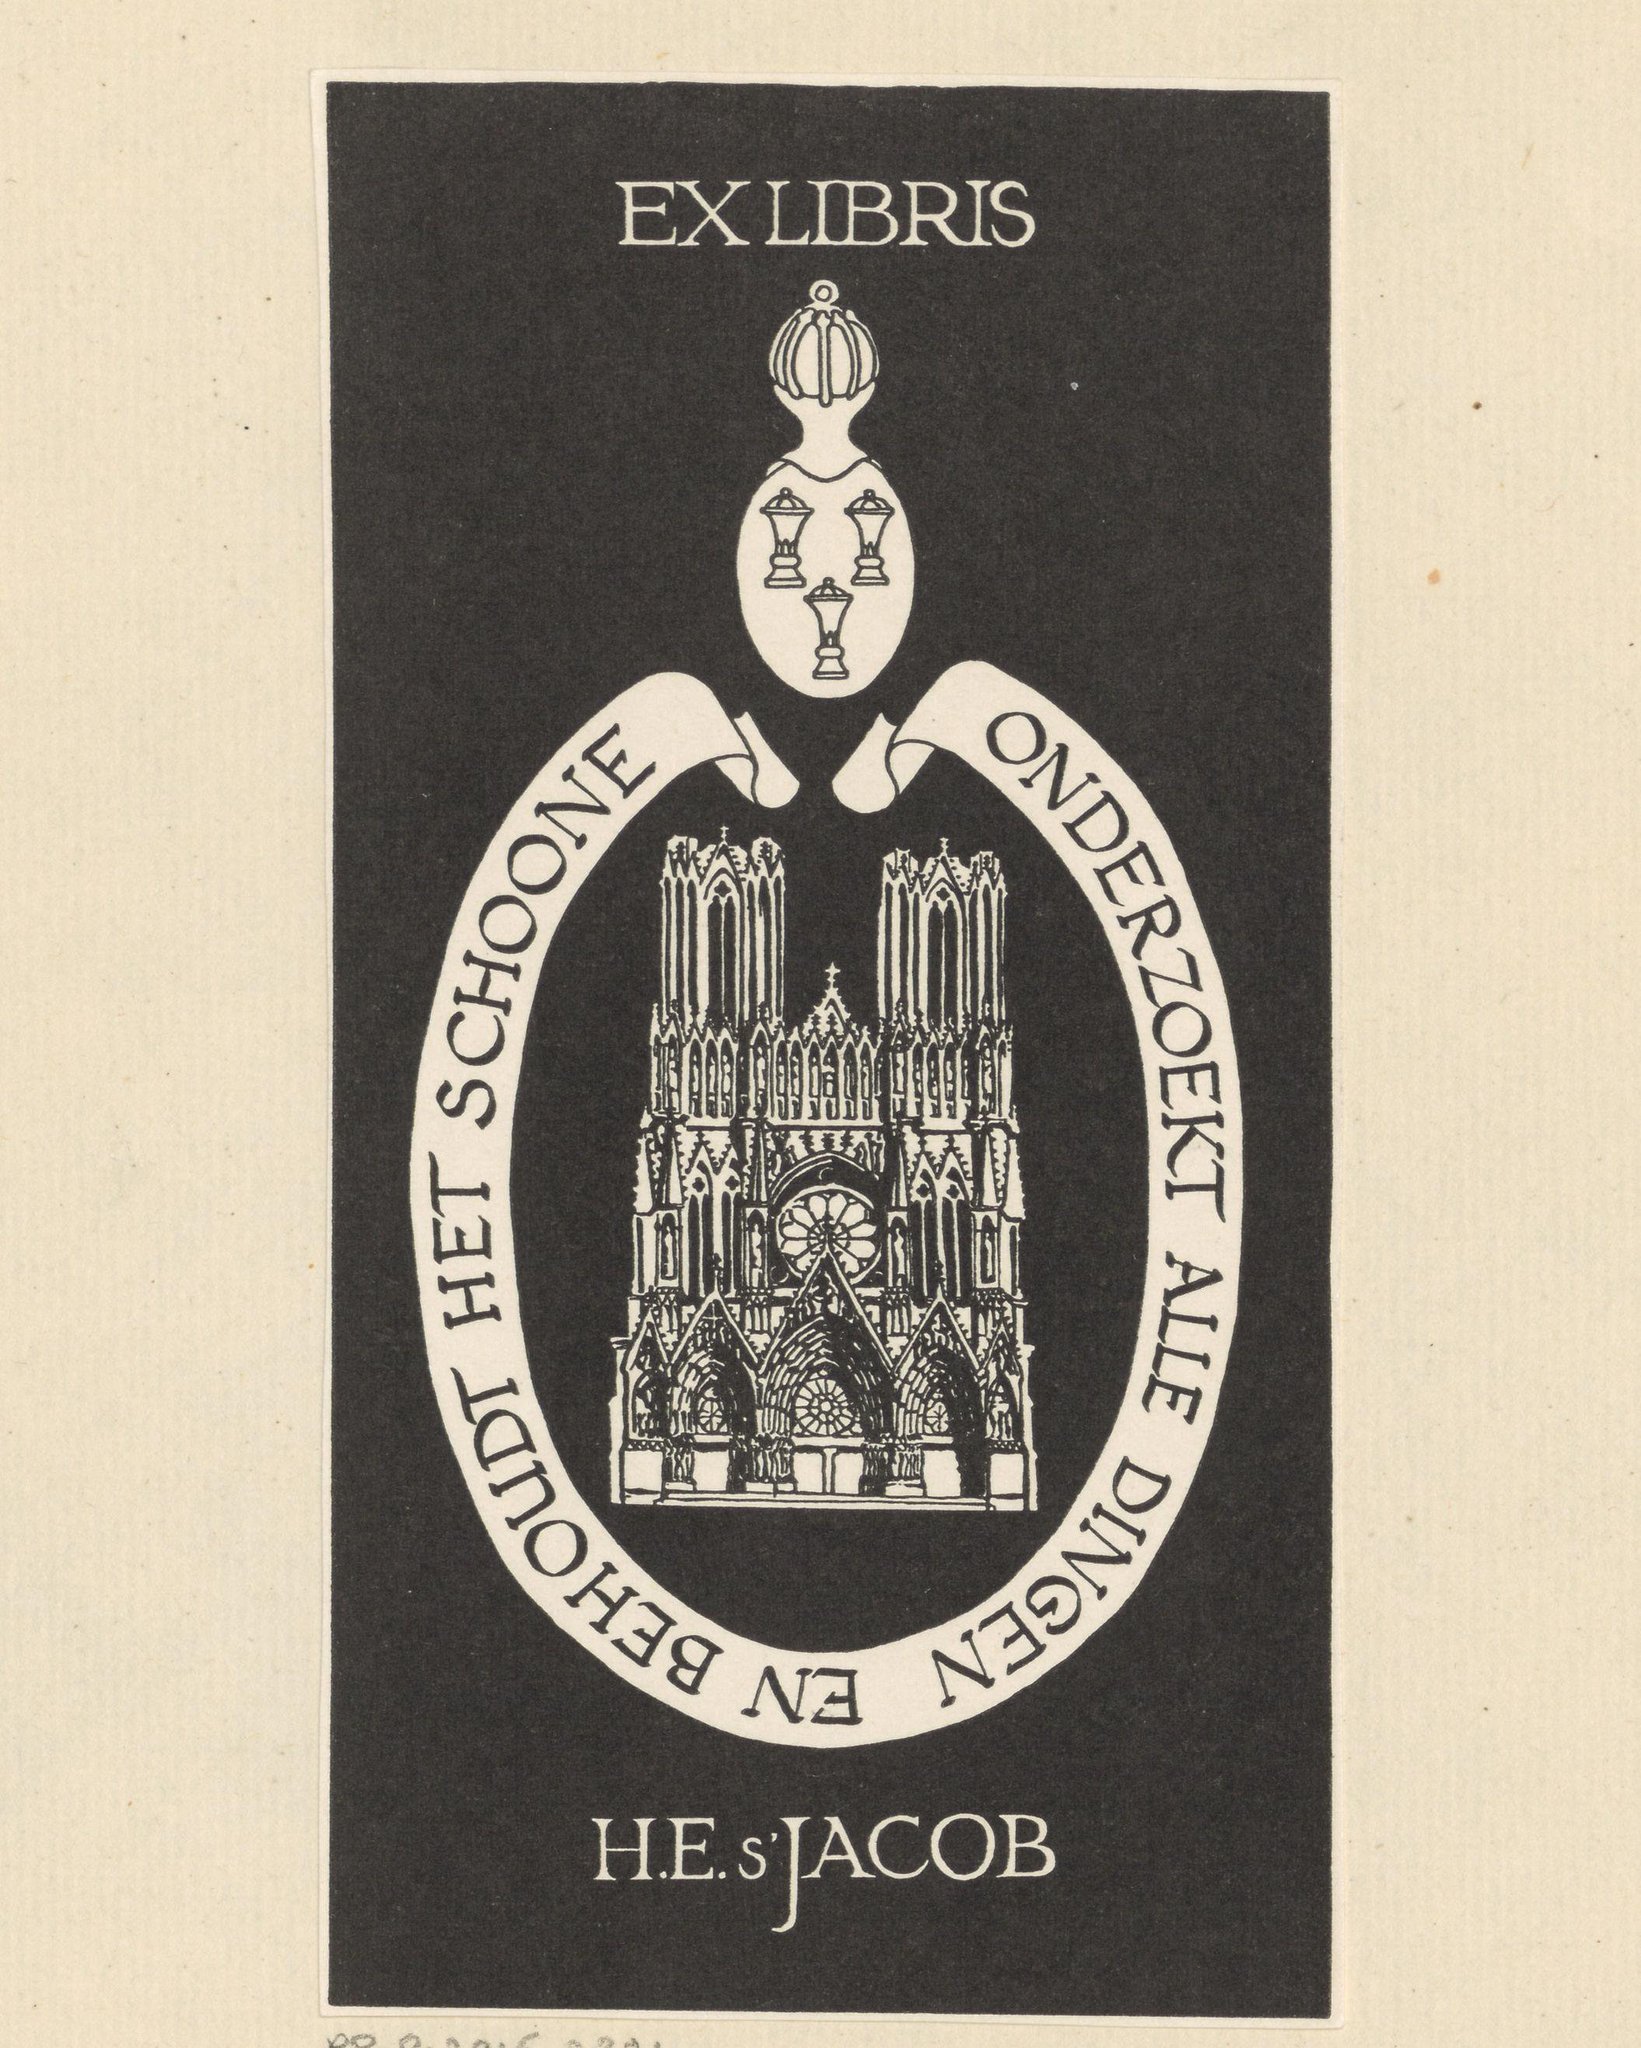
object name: bookplate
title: Onderzoekt alle dingen en behoudt het schoone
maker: Anonymous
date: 1900-1999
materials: paper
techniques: printing block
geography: netherlands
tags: roman catholic church, armorial bearing, heraldry